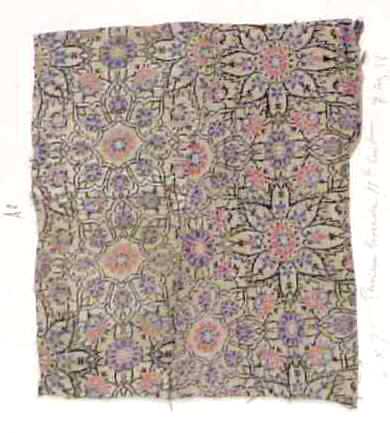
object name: textile fragment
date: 1601-1700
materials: silk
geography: iran